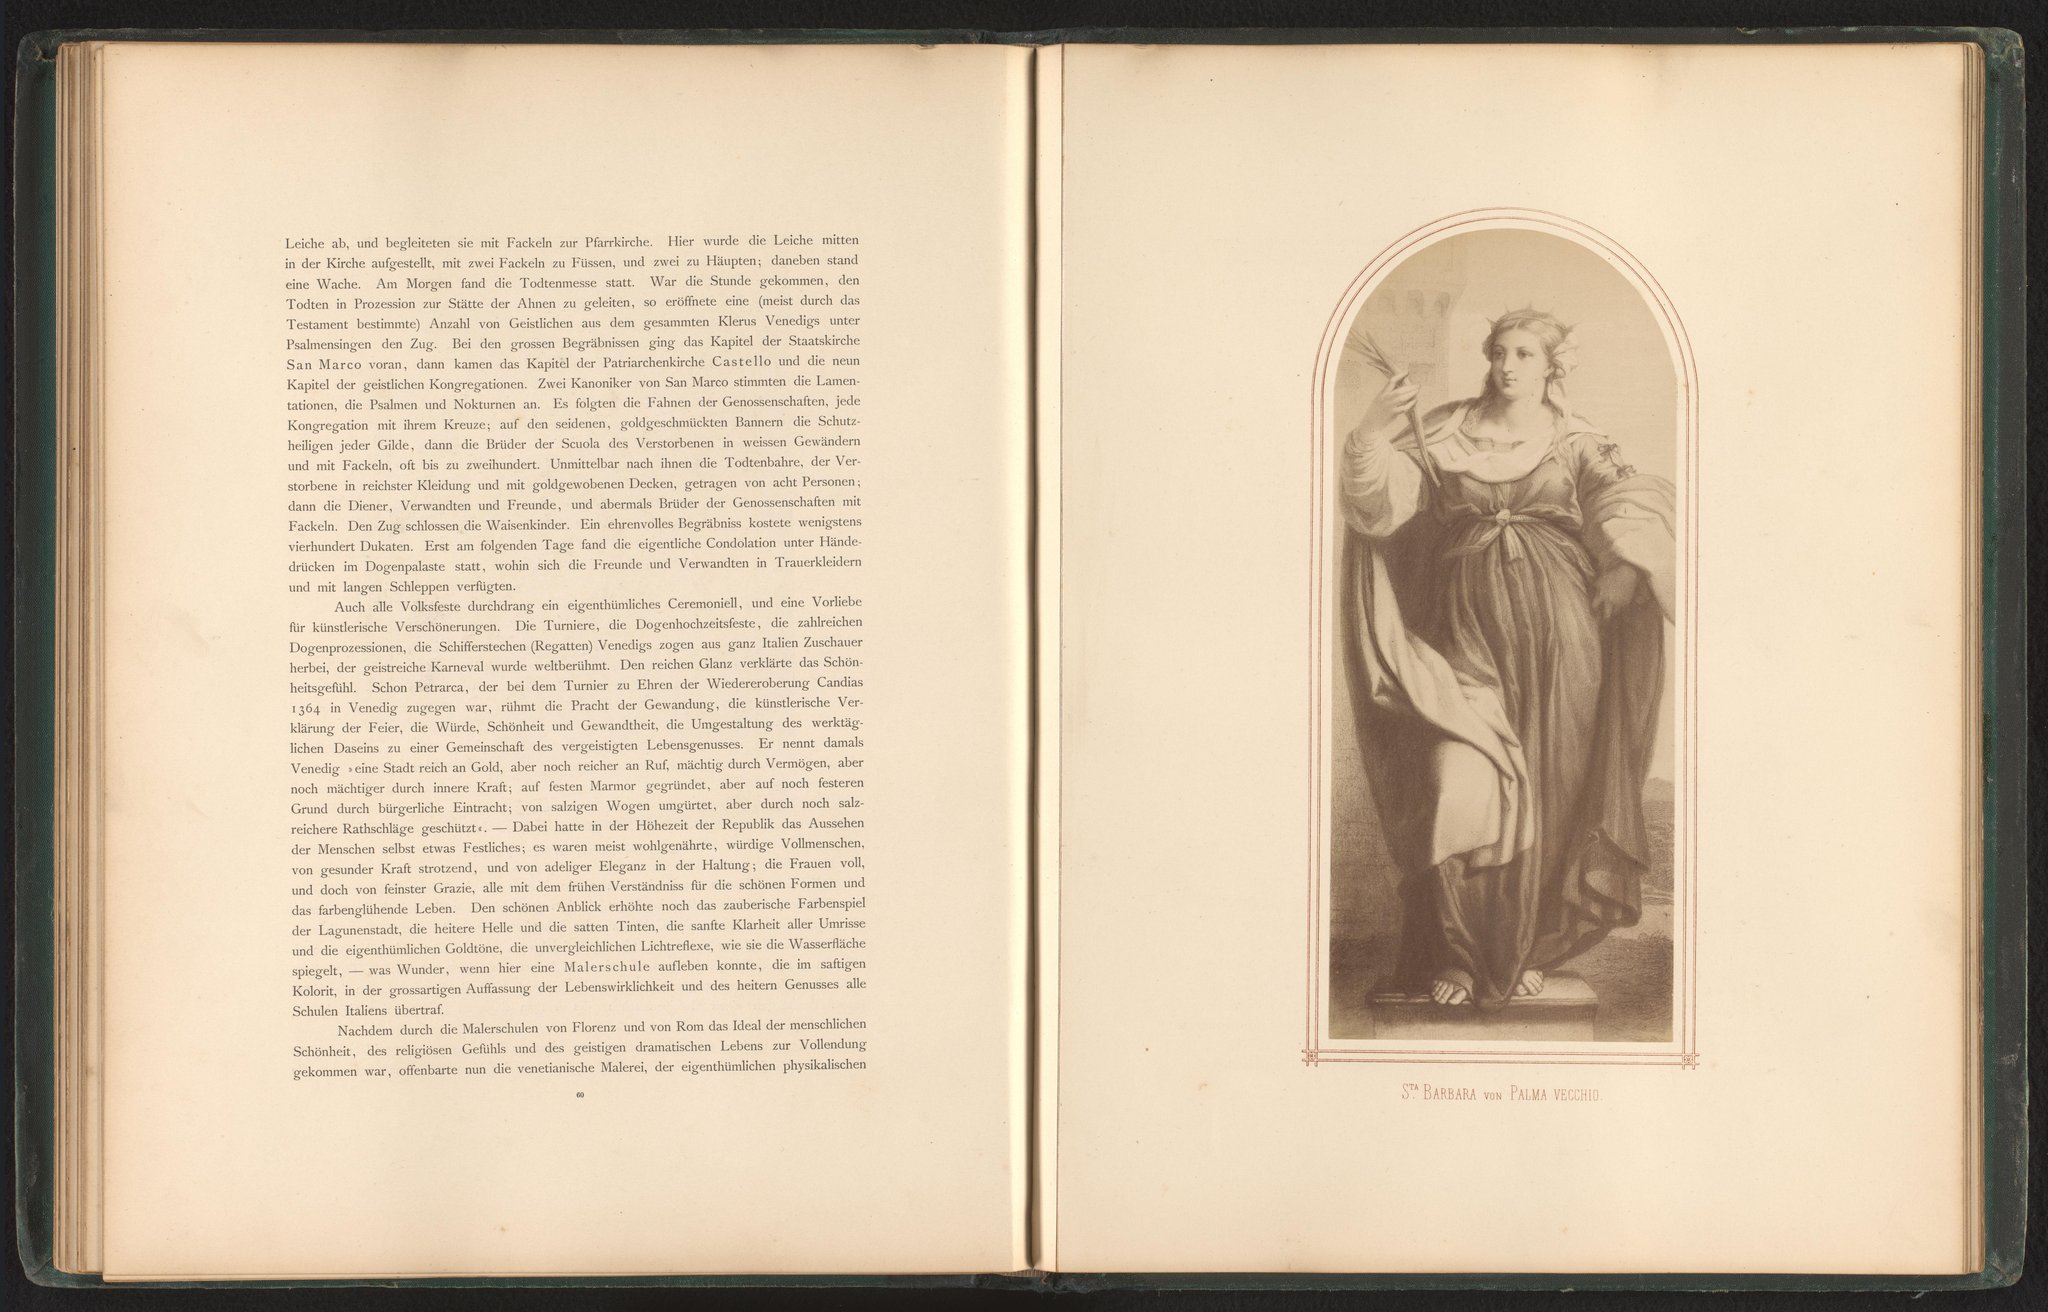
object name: page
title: Fotoreproductie van een schilderij van Sint Barbara door Jacopo Palma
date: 1870-1875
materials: paper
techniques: albumen print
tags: the virgin martyr barbara; possible attributes: book, cannon(ball), crown, cross, chalice with wafer, dioscuros (her father), peacock feather, sword, torches, mason's tools, tower, picture, painting